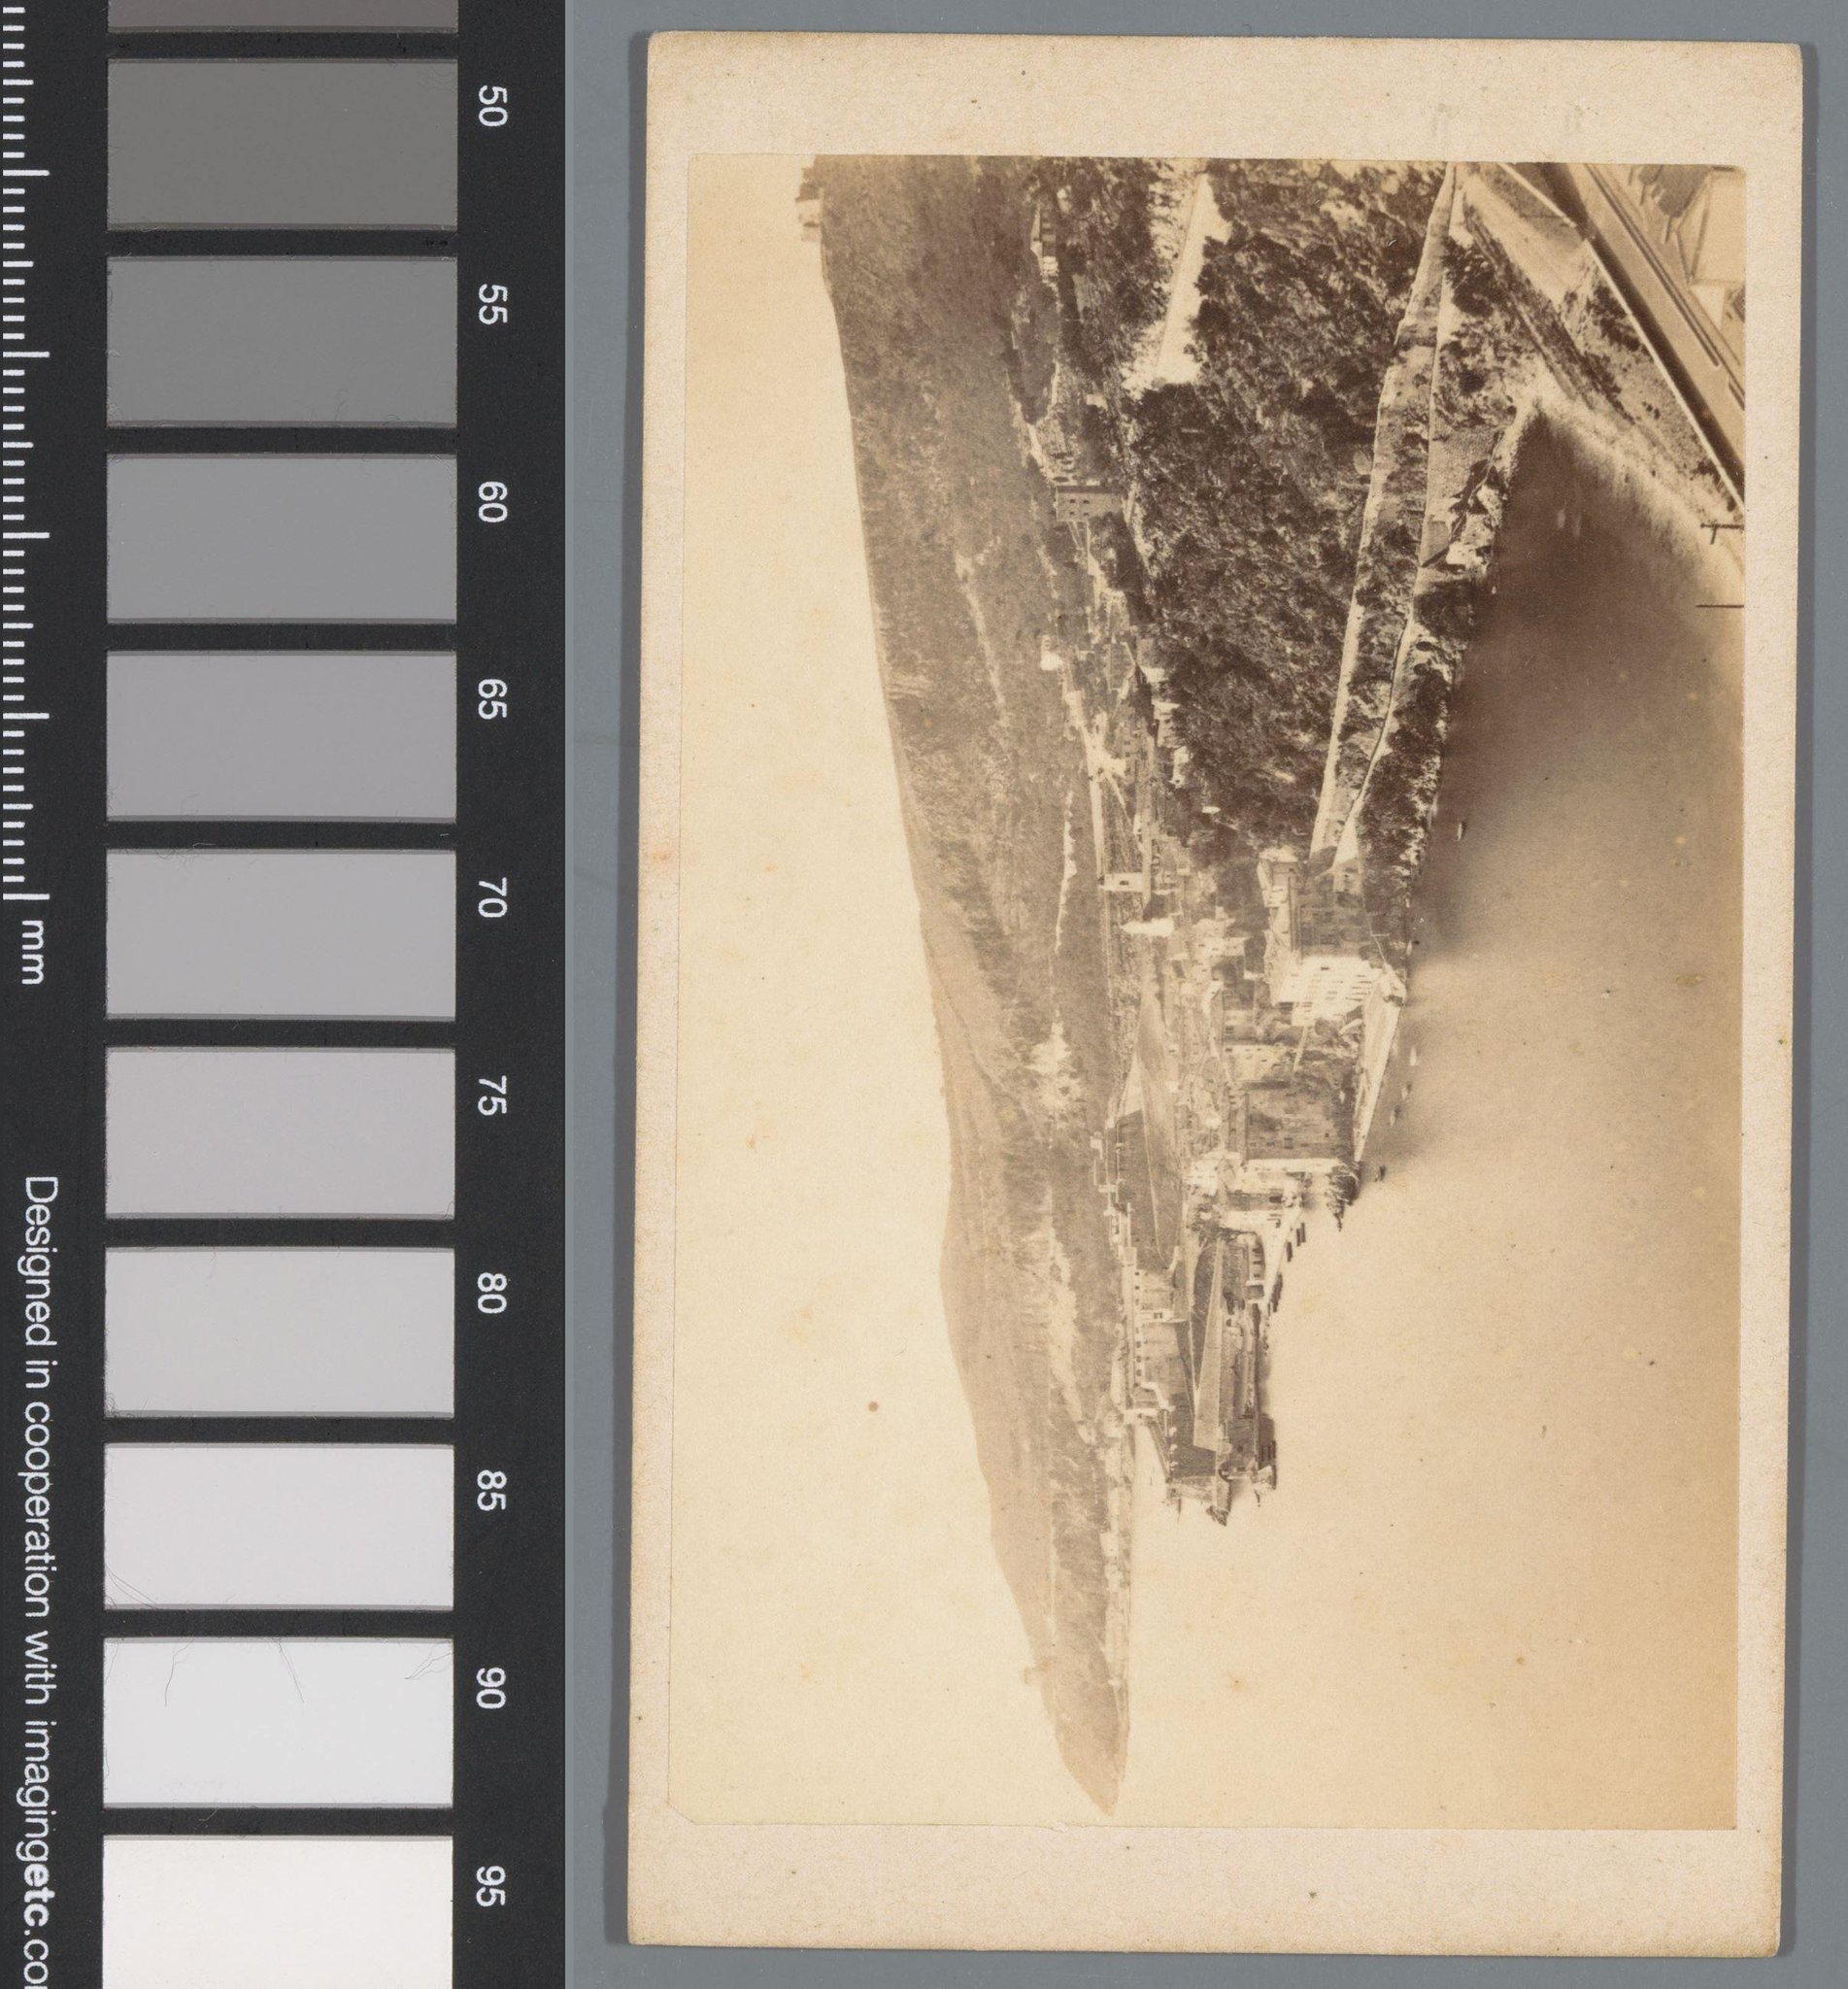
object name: carte de visite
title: Gezicht op de kust van de Rivièra di Ponente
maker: celestino degoix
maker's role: fotograaf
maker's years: 1825-1902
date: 1860-1890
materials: cardboard, paper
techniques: albumen print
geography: italian riviera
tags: city-view in general; 'veduta', coast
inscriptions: inscription: ‘C. Degoix/ fotografo/ brevettato/ da S.M. il Re d'Italia/ Via Carlo Felice/ No. 10/ Genova/ N. 365/ C. Degoix - Fotografo a Genova’